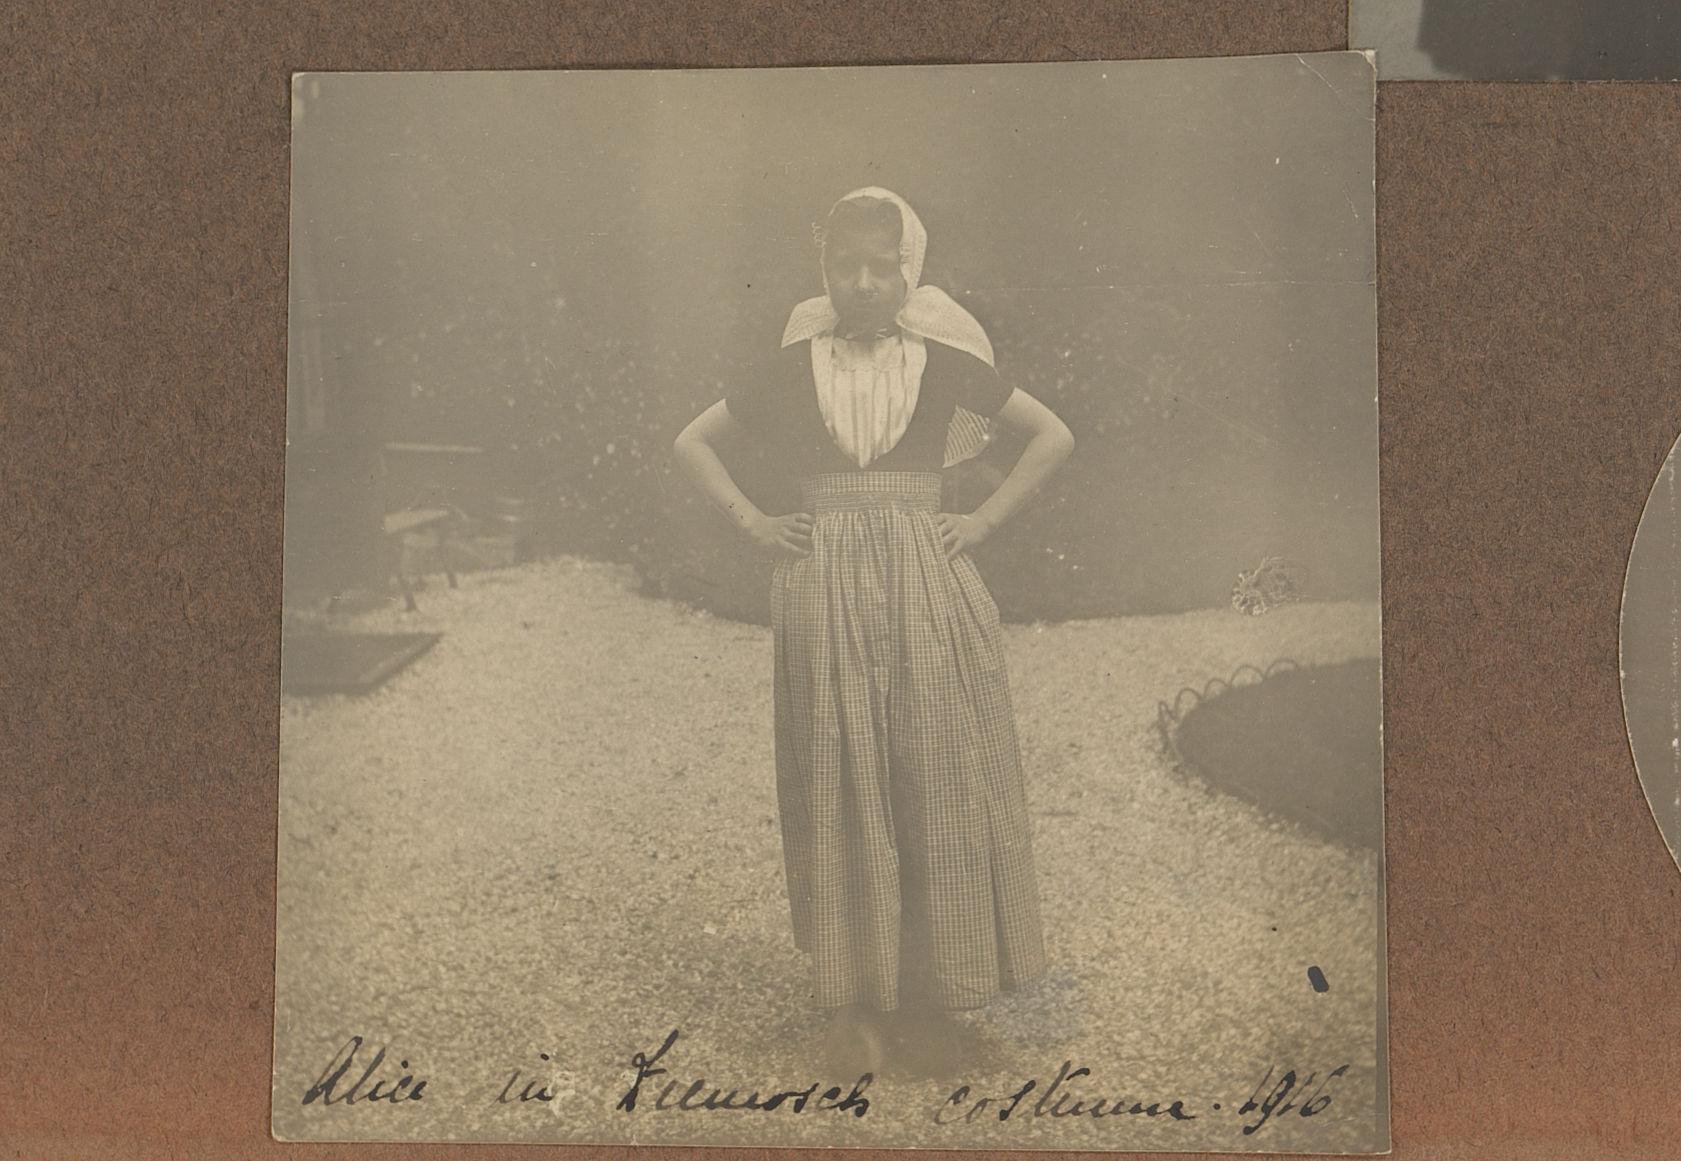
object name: photograph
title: Alice in Zeeuwse klederdracht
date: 1916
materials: photographic support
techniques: photography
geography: netherlands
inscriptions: inscription: ‘Alice in Zeeuwsch costuum . 1916’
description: Foto op bruin albumblad 27 van familiealbum van Alphons Diepenbrock.